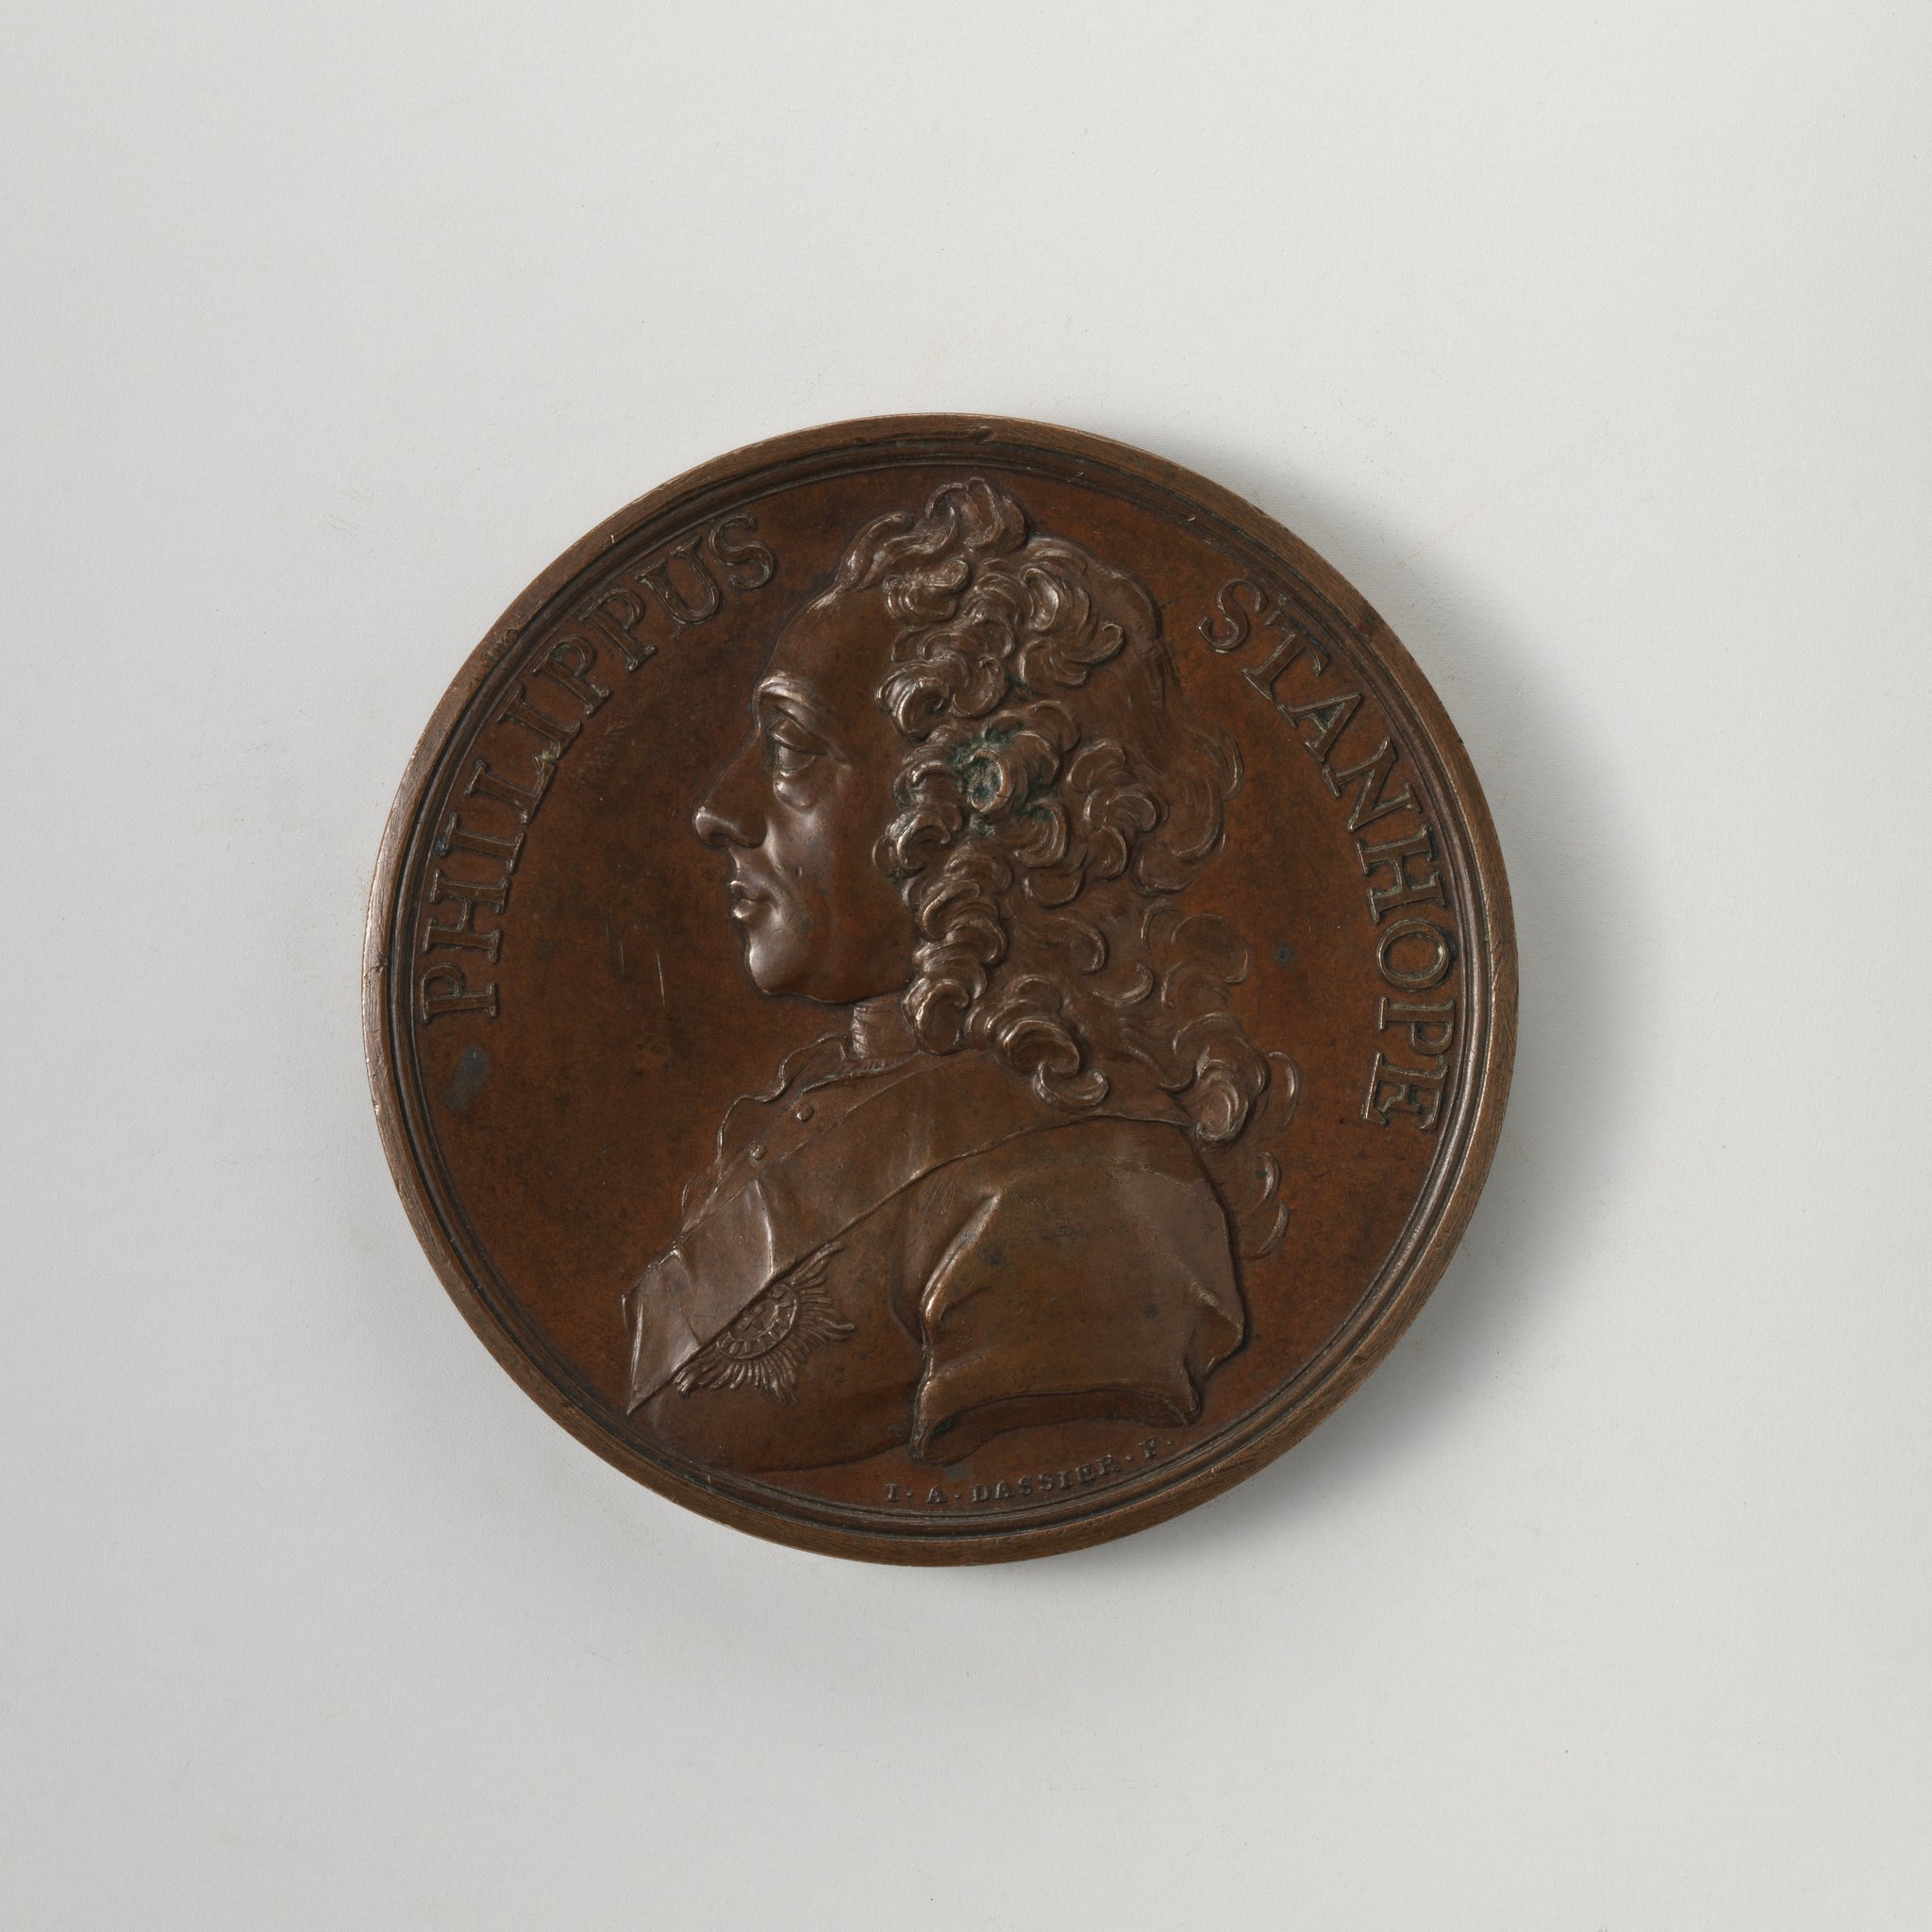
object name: medal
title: Philip Stanhope, 4th Earl of Chesterfield (1694–1773)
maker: jacques-antoine dassier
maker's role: artist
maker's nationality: swiss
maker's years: 1715-1759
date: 1743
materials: bronze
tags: faces,men,portraits,profiles